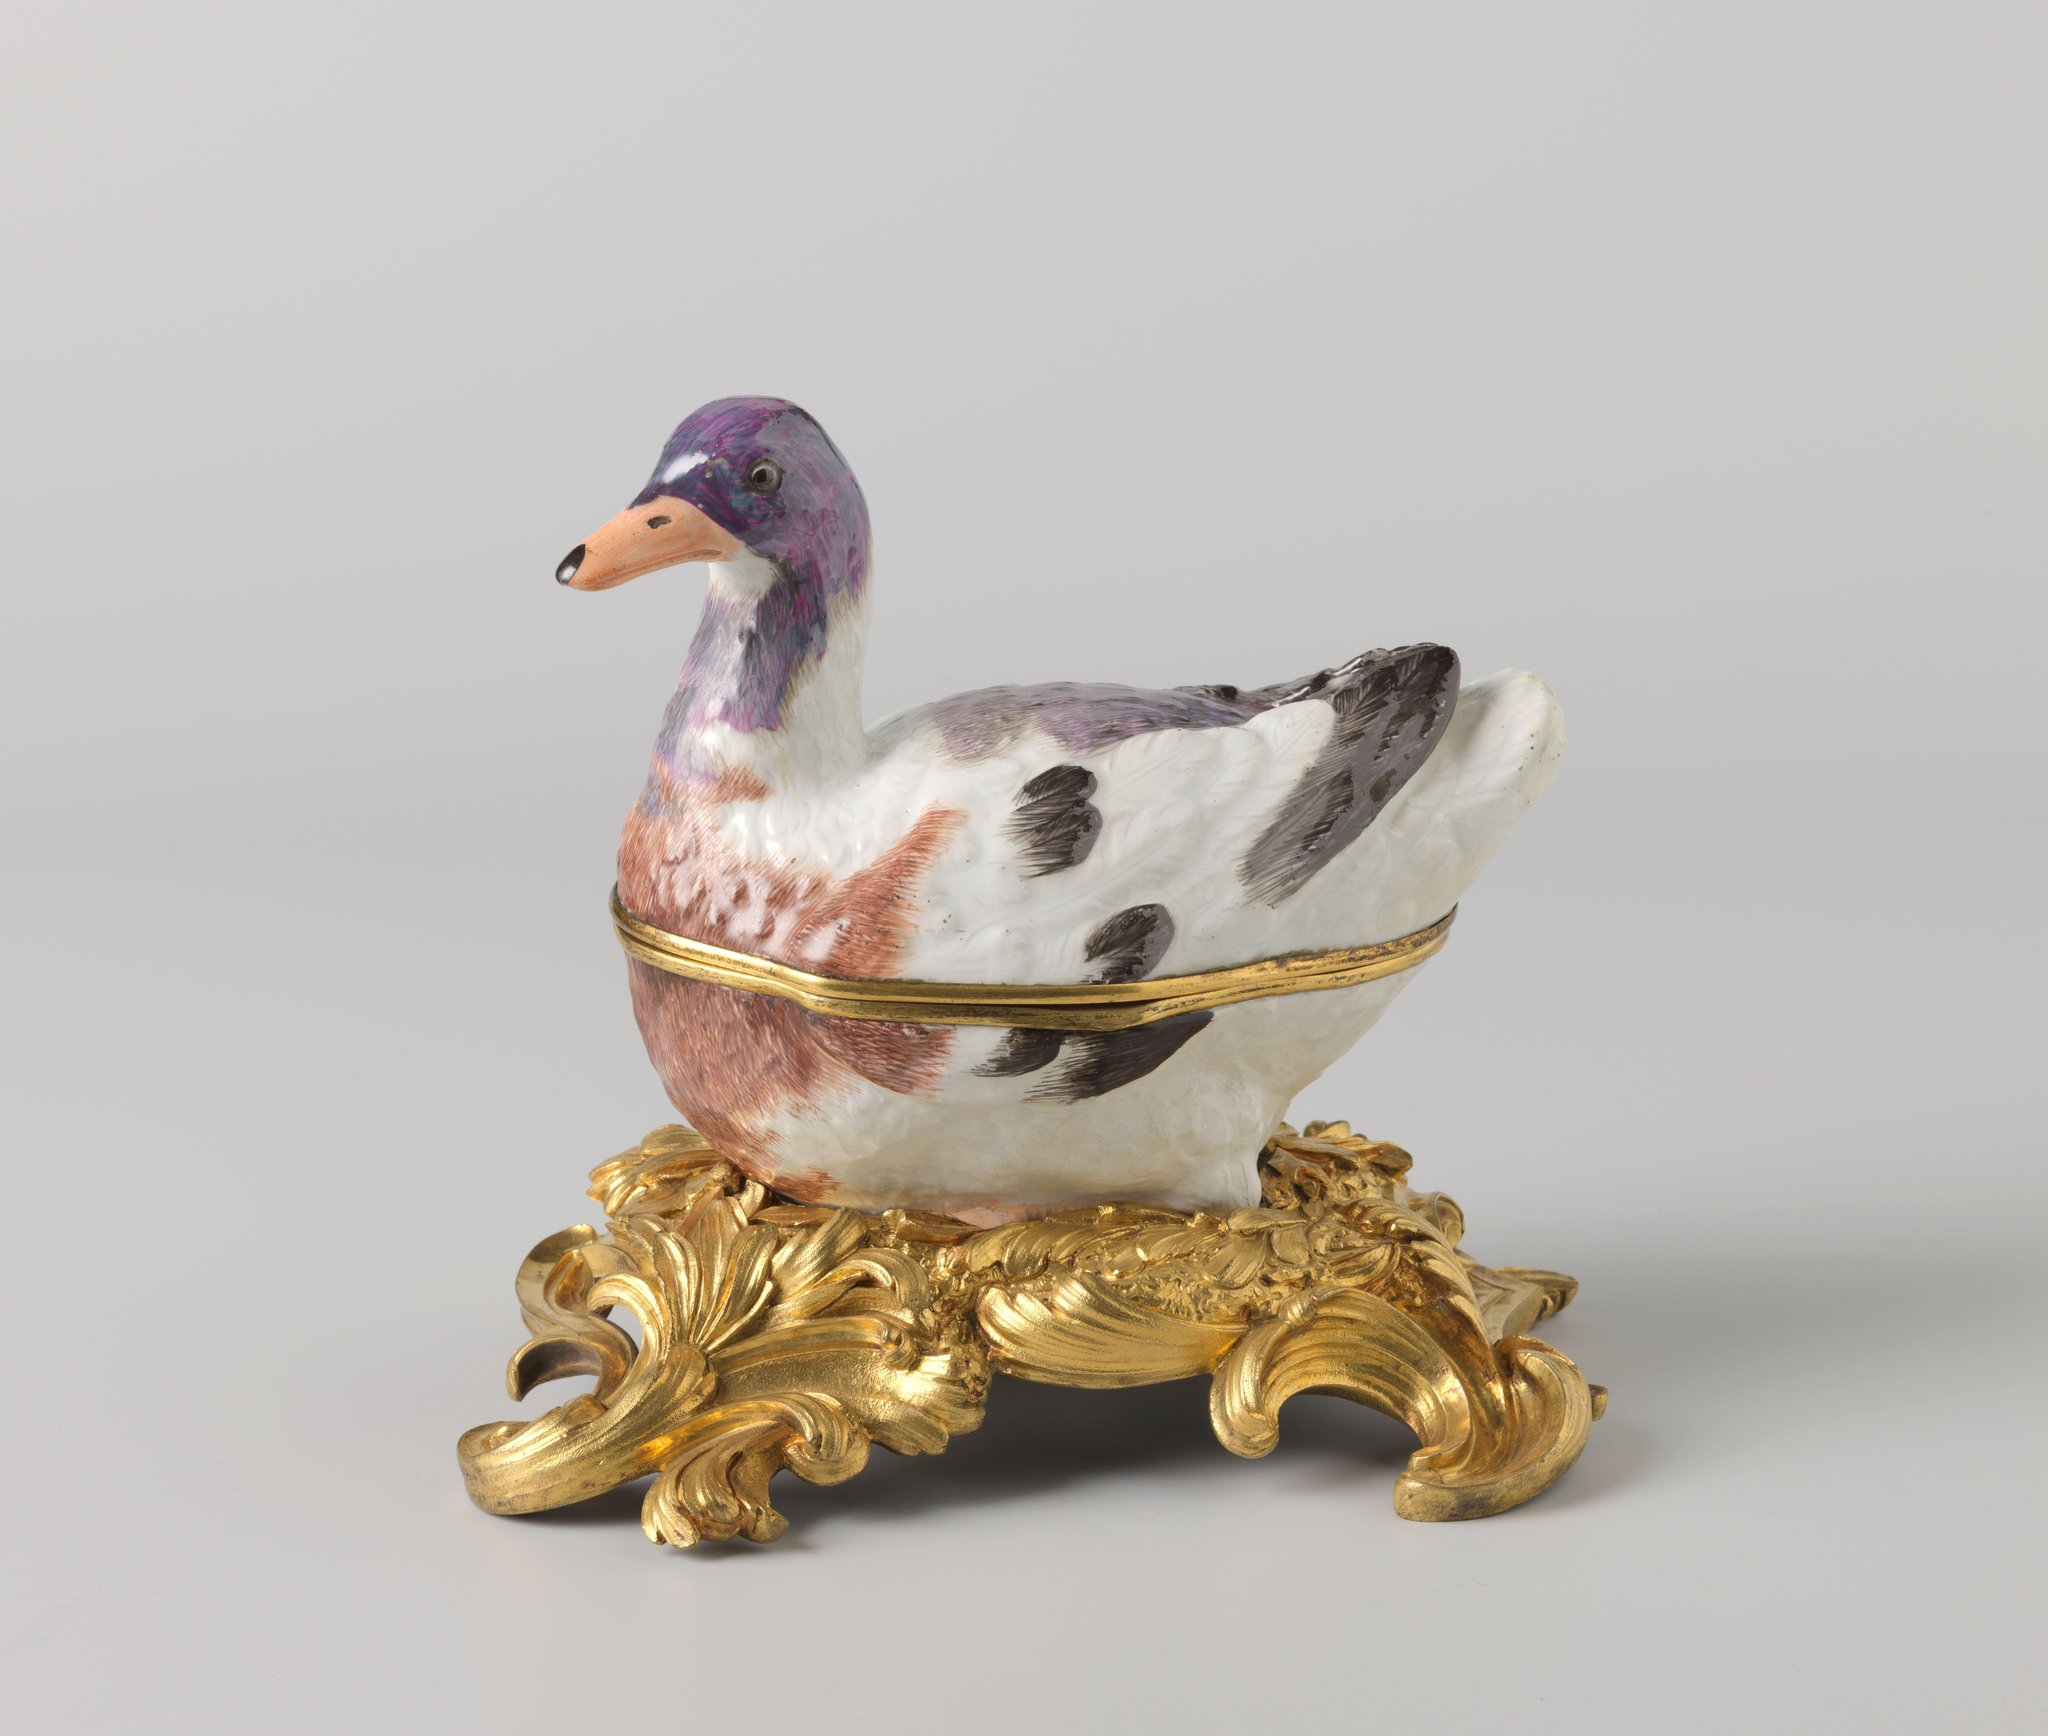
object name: base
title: Verguld bronzen rococo-voetstuk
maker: johann joachim kändler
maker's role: designer, sculptor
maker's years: 1706-1775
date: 1740-1748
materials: bronze, porcelain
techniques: gilding, painted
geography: meissen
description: De eend zit op een verguld bronzen rococo-voetstuk.